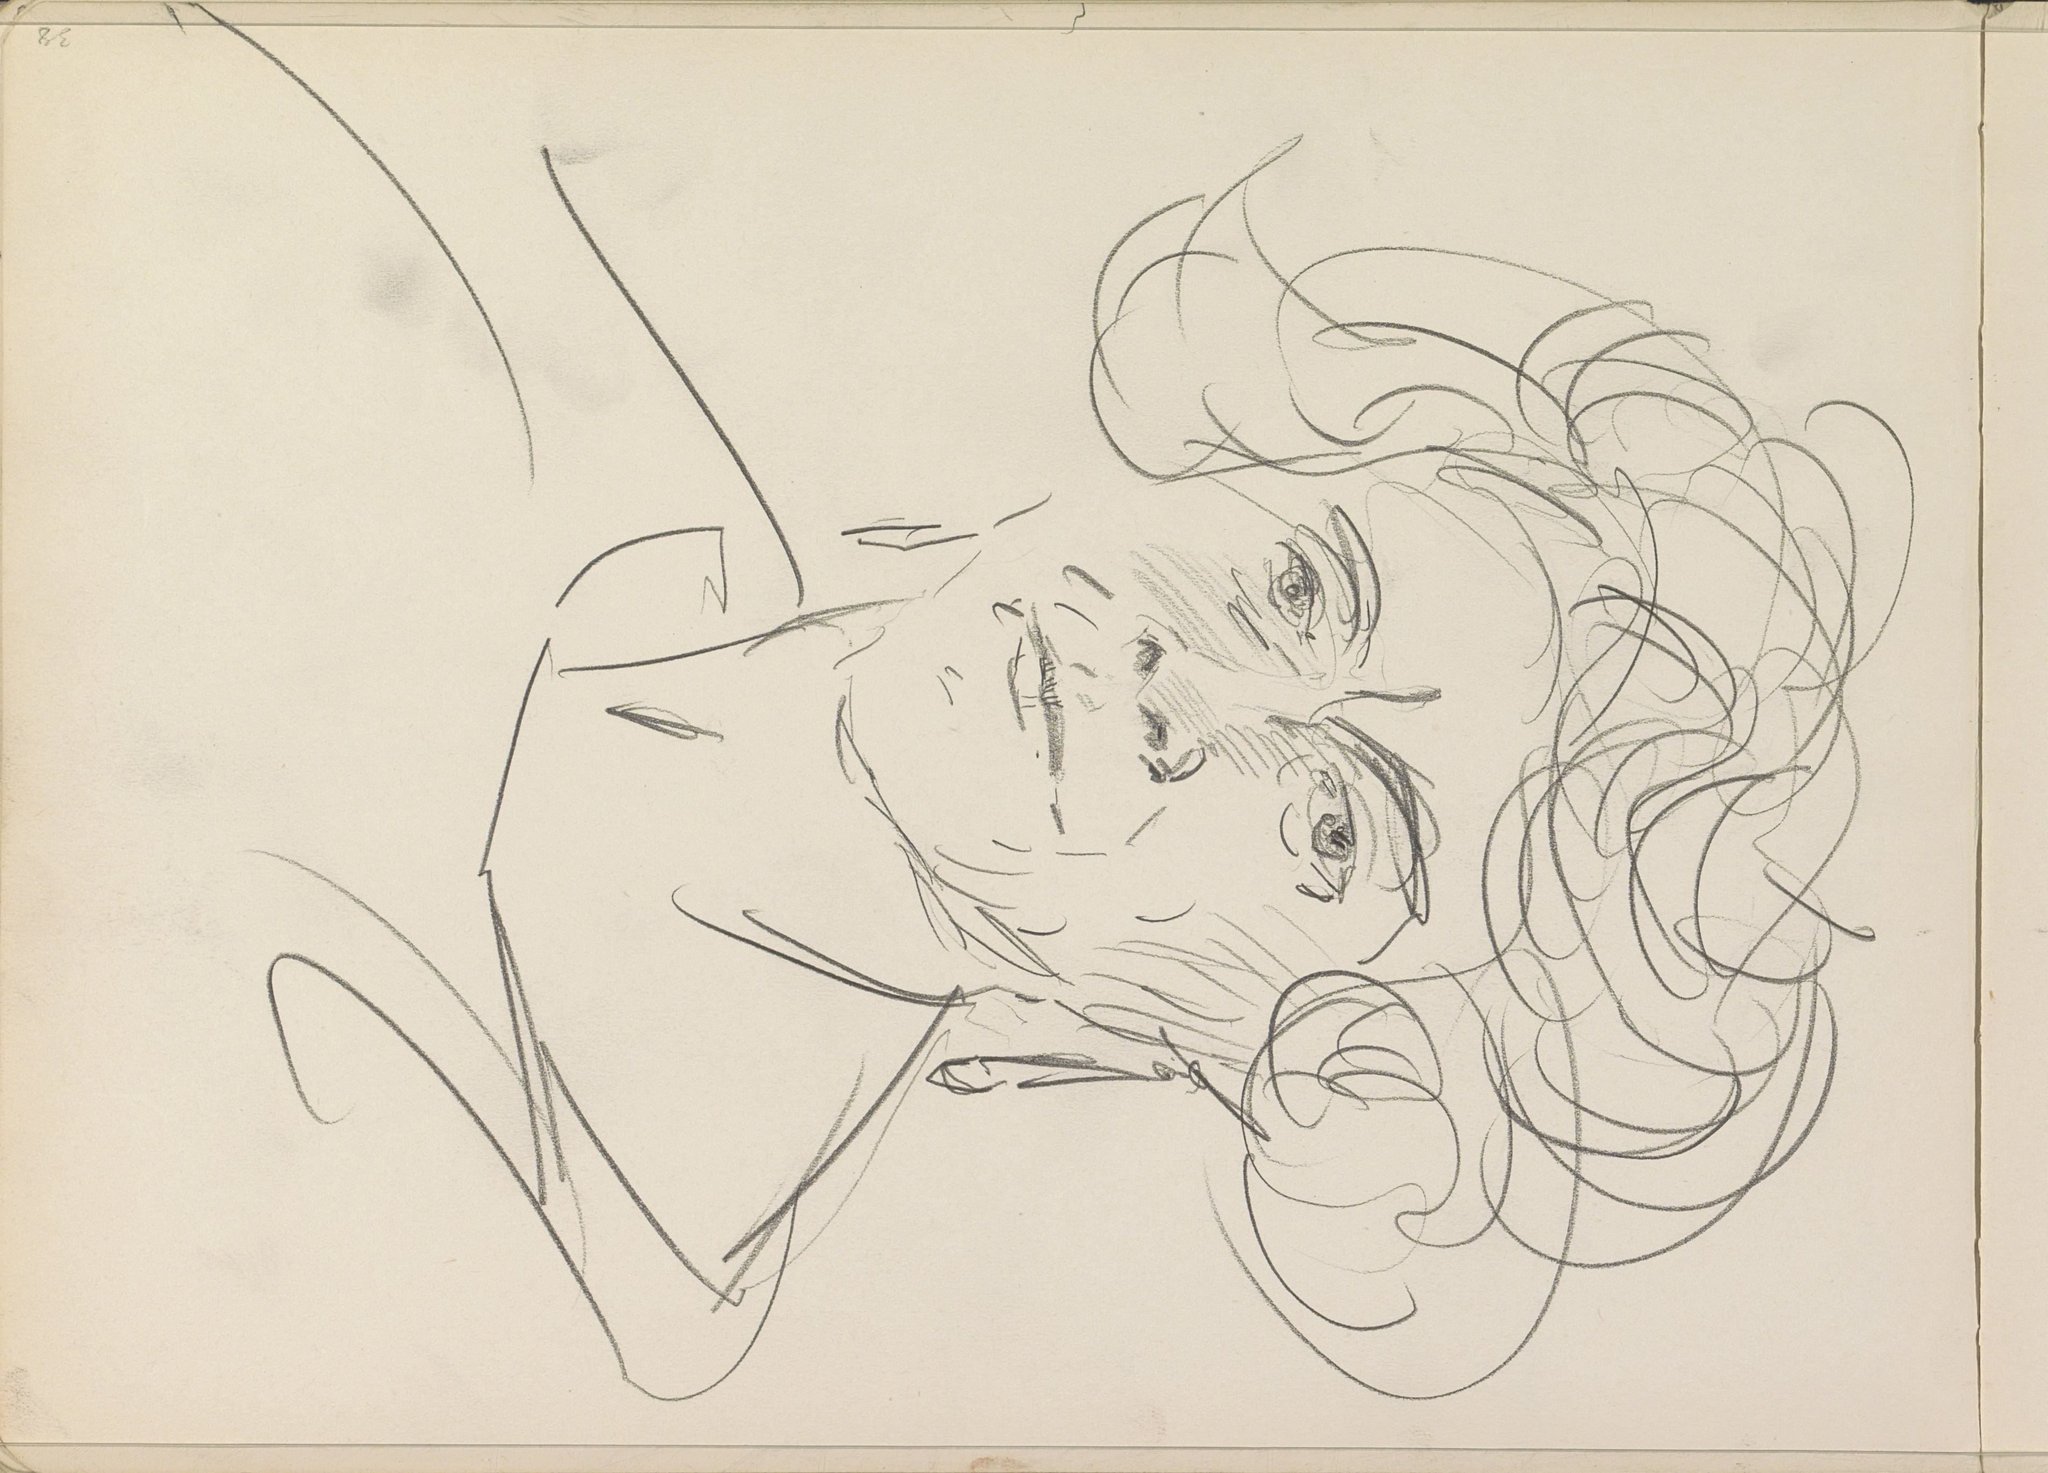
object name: sketchbook leaf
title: Portret van een onbekende vrouw met oorbellen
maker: isaac israels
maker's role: draughtsman, painter, print maker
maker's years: 1865-1934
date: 1915-1934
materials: paper, pencil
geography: the hague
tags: anonymous historical person portrayed alone - bb - woman, ear-rings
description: Blad 29 verso uit schetsboek VI met 33 bladen.